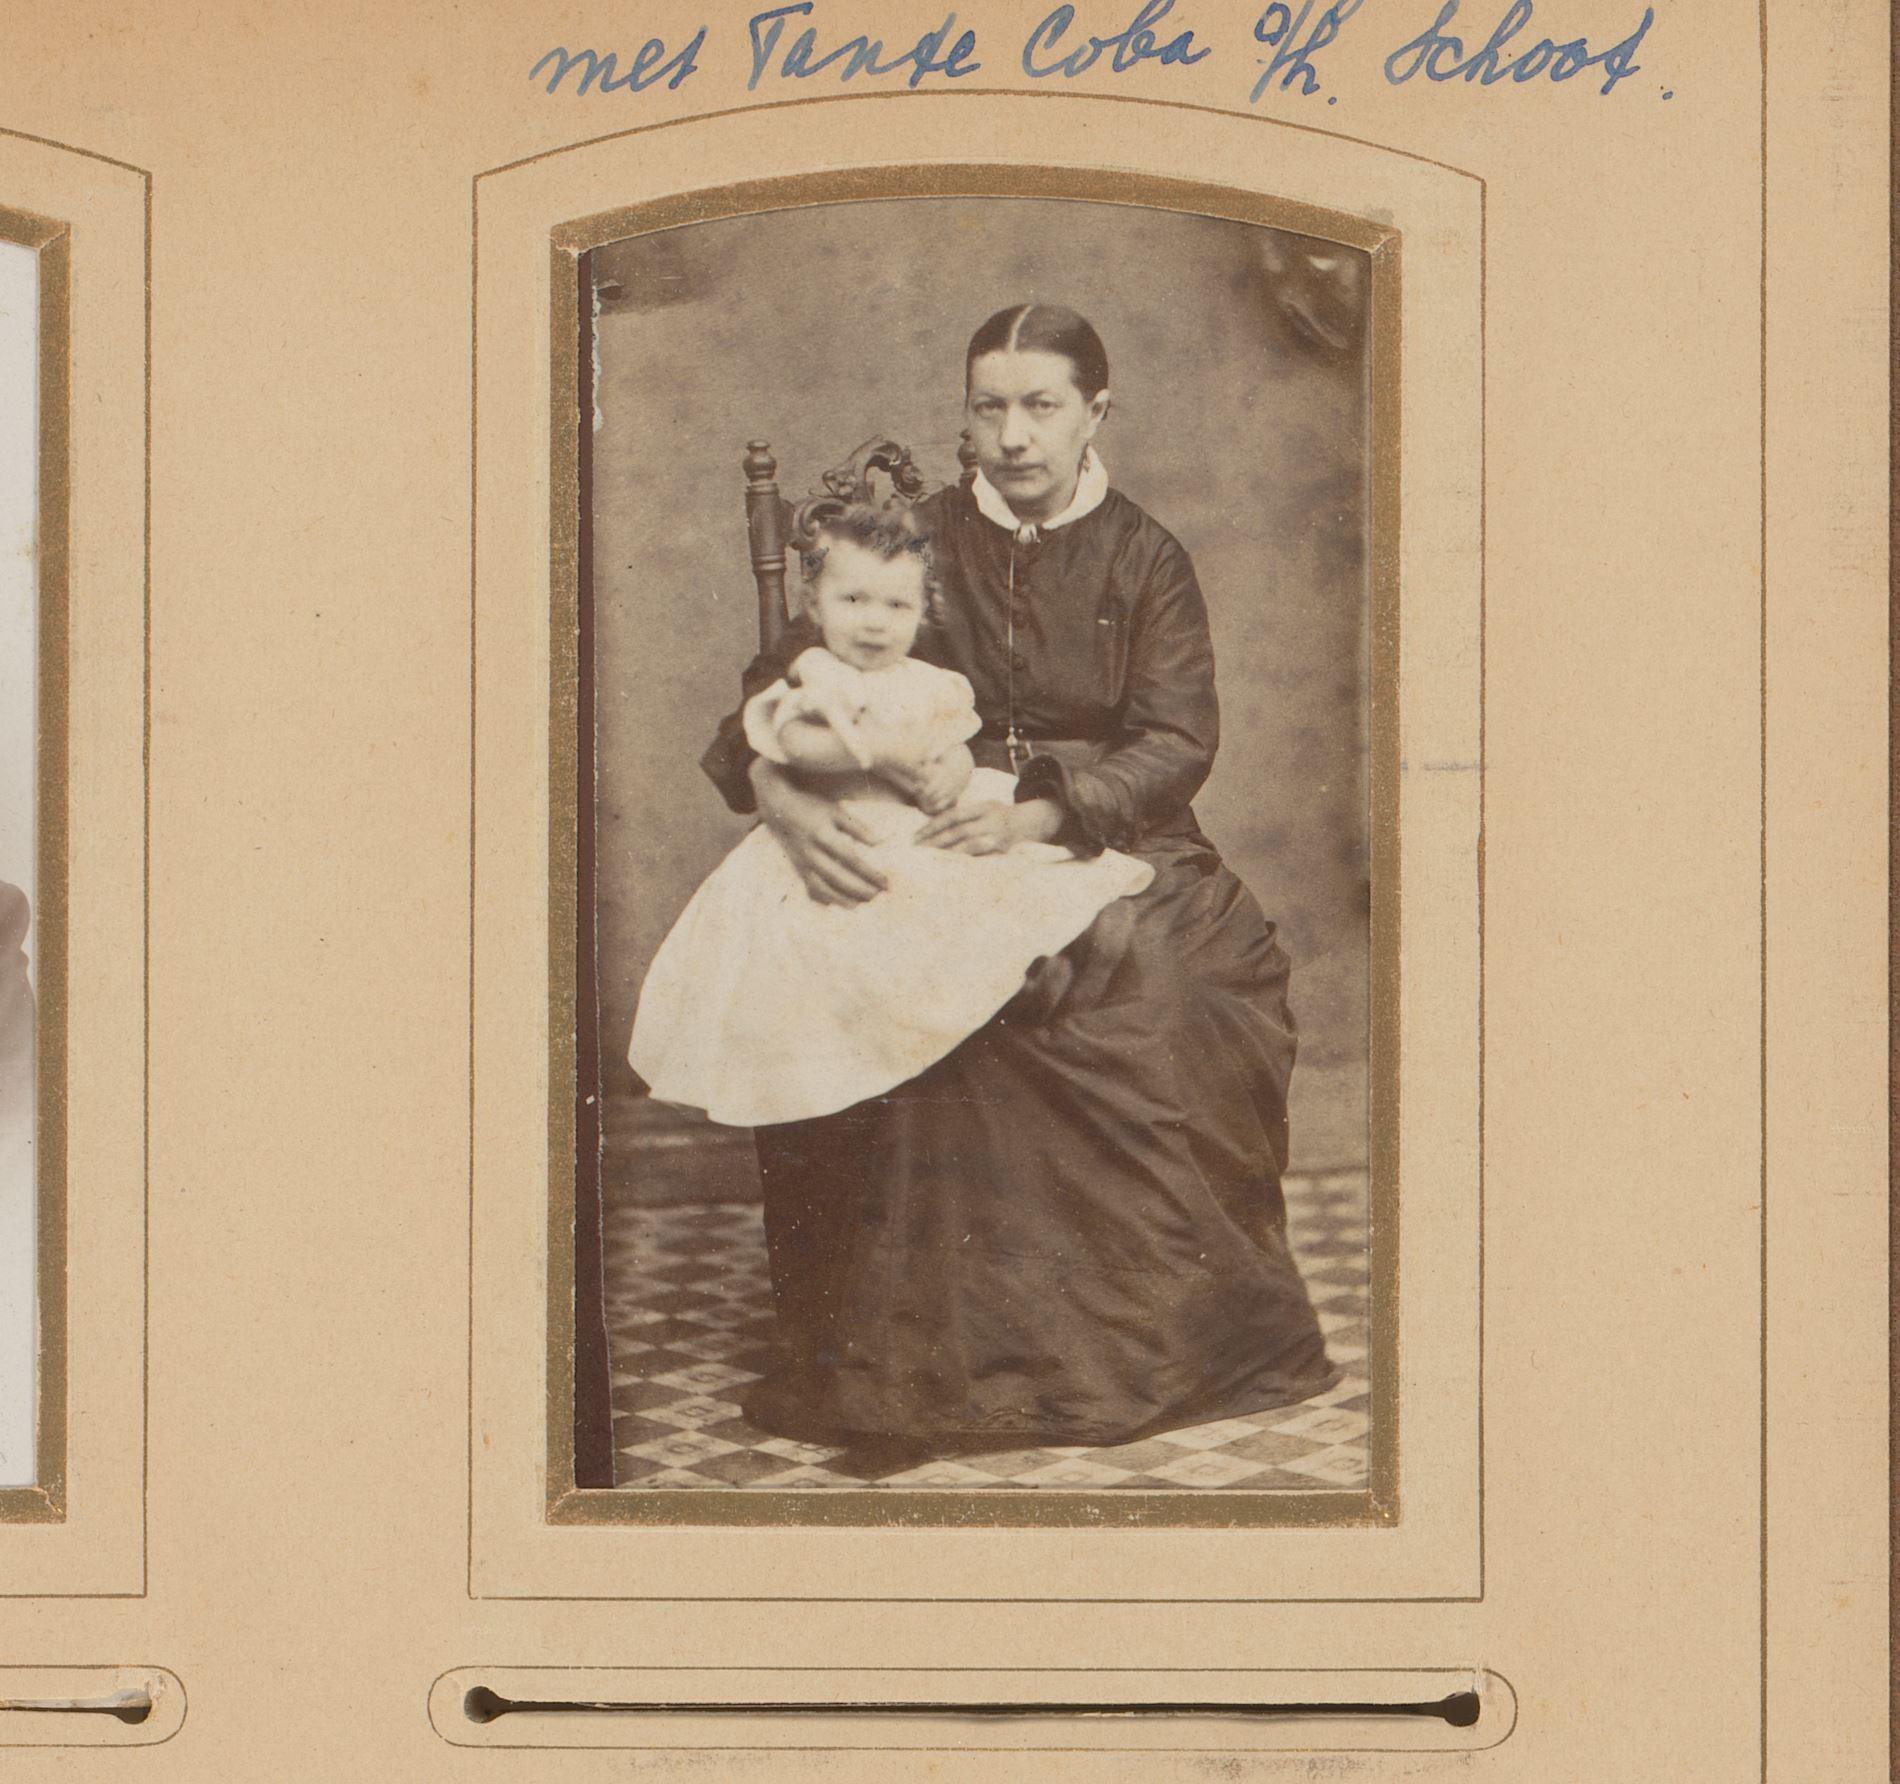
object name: photograph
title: Portret van een grootmoeder Roos, met Coba Roos op schoot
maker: gijsbertus aloysius clemens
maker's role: fotograaf, vergulder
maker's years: 1841-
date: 1870-1890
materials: cardboard, photographic support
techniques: albumen print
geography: amersfoort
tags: historical persons - bb - woman, toddler (female), grandparent(s) with grandchild(ren) (family group)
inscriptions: annotation: ‘grootmoeder Roos i/d/ rouw over haar zoontje Coos/ met Tante Coba o/h. schoot.’, inscription: ‘G.A. CLEMENS AMERSFOORT’